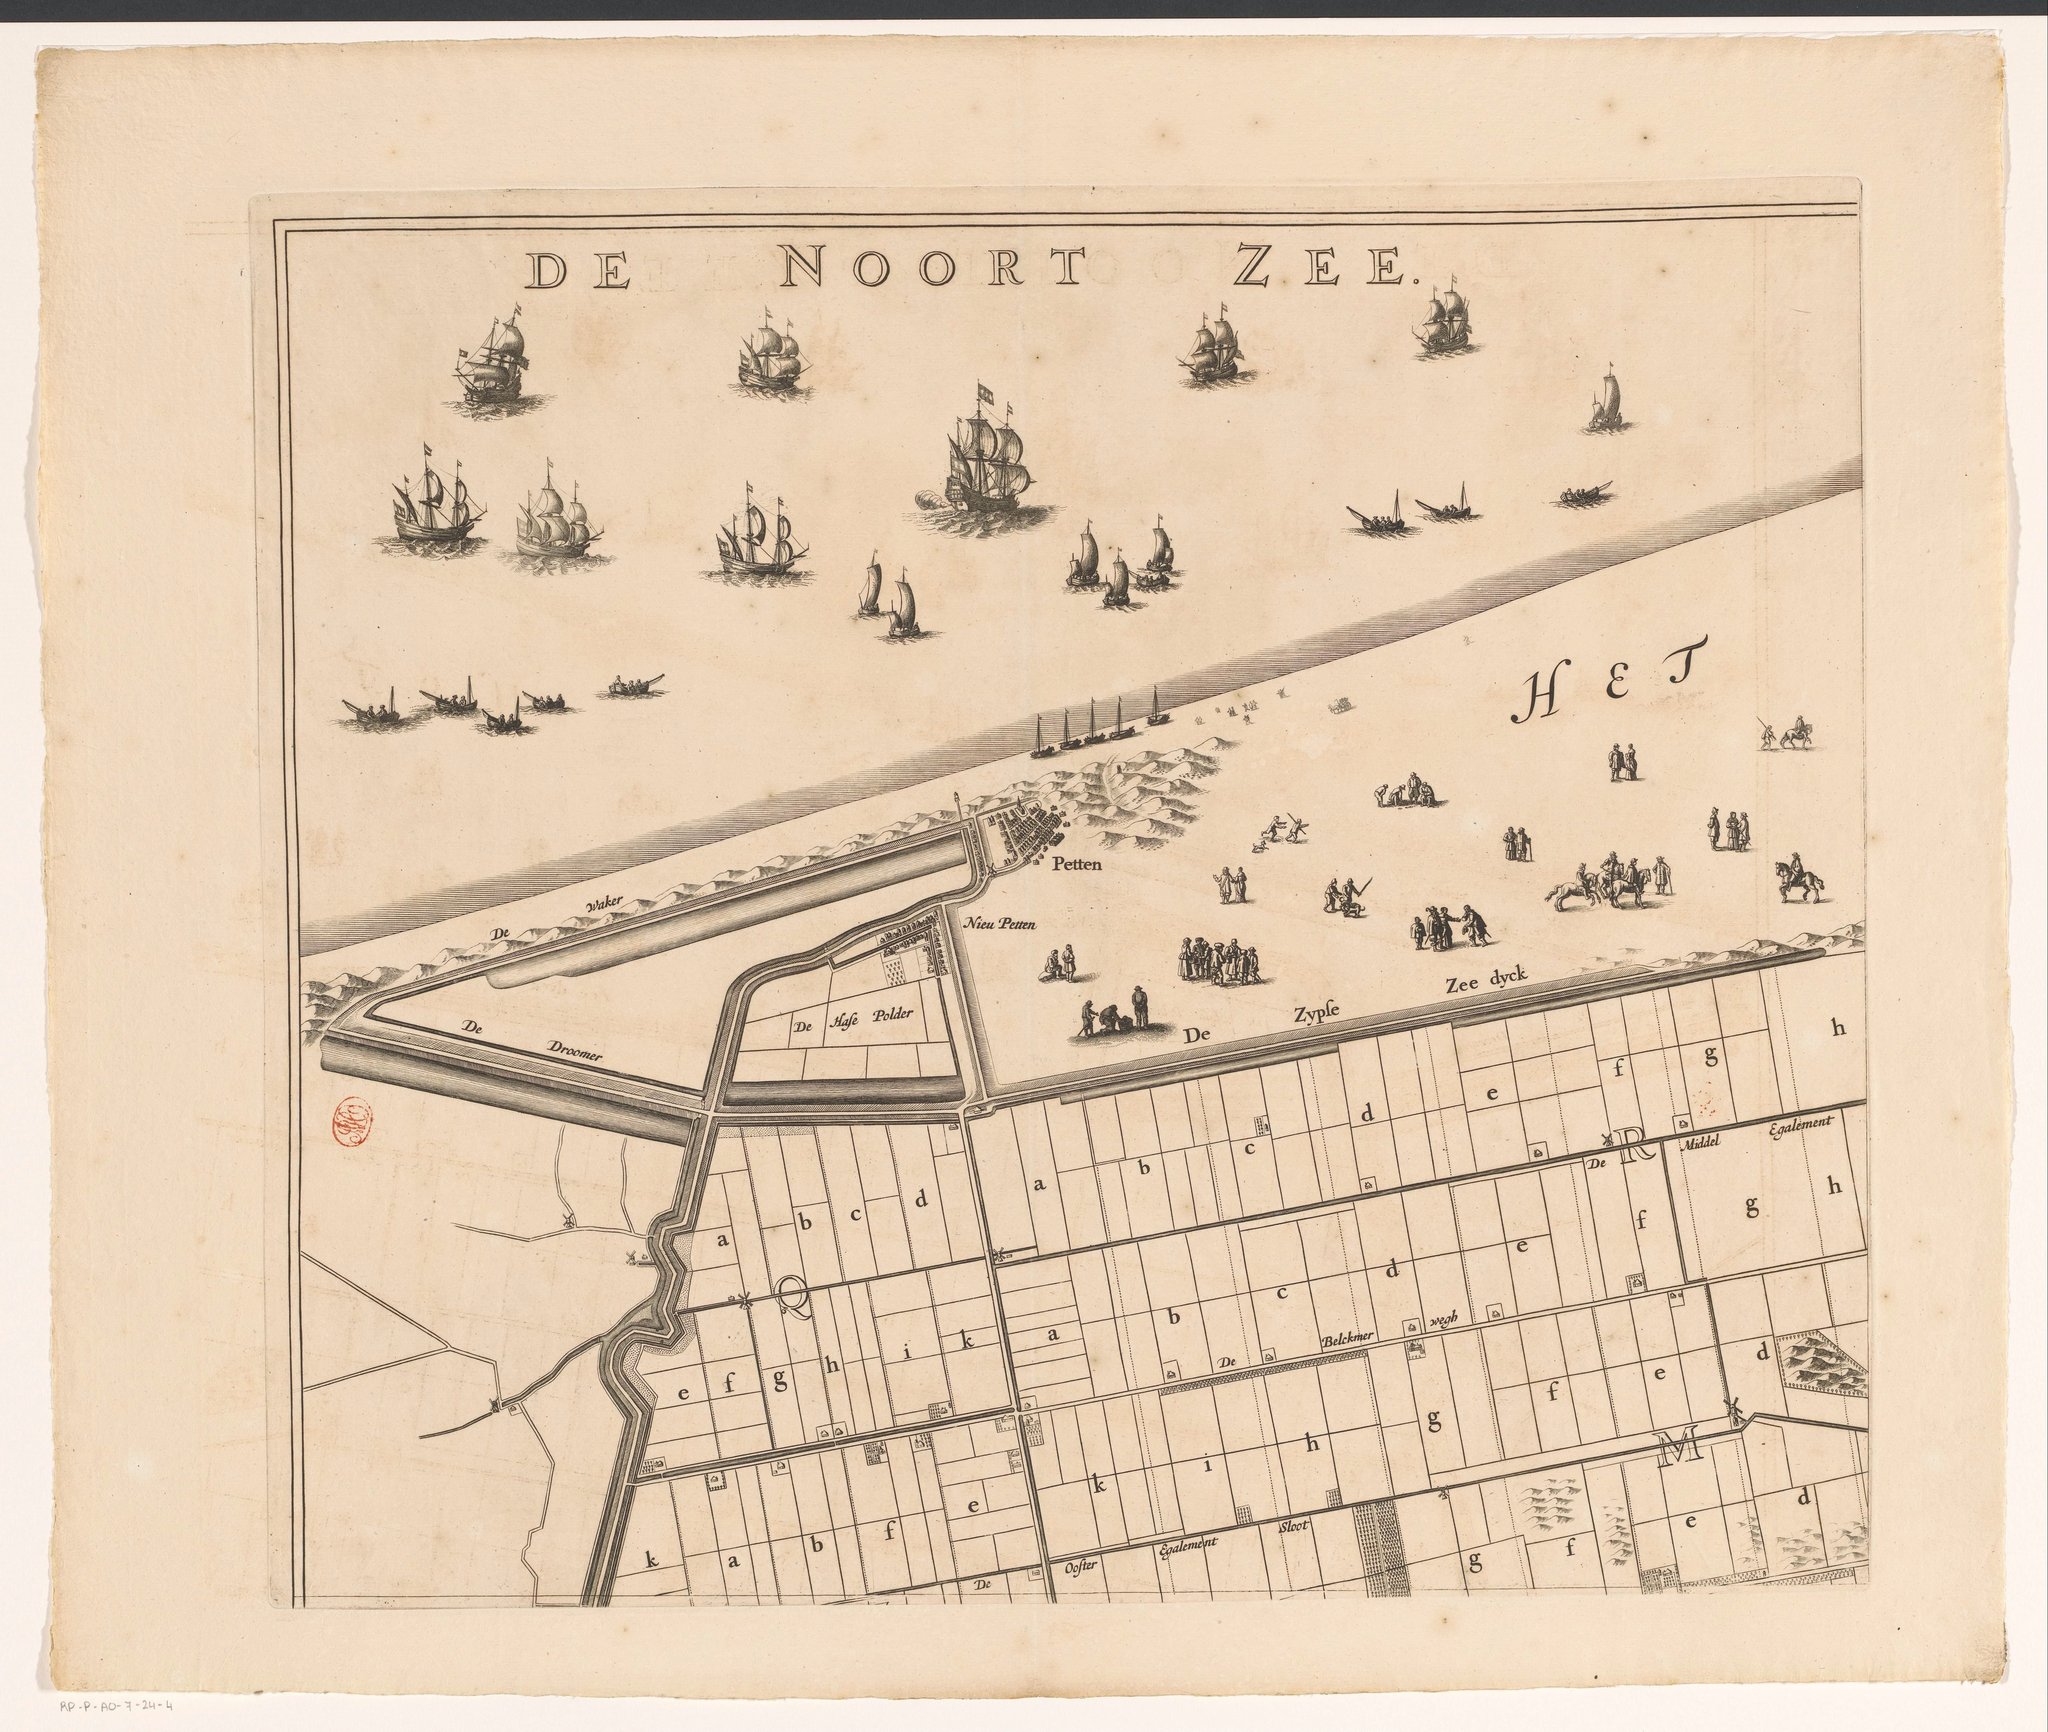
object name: map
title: Afbeelding van de Zyp. Haer waere gelegentheit van dyckage, weegen, watringen en schey-slooten; alle de hofsteden, wooningen en watermolens inde selve geleegen: mitsgaders rechte aenwysinge van de scheydinge haerder groote en kleyne letteren. Begrypende in haren omring de somme van 9060 morgens, yder tot 600 Roeden Hontsbosscher maet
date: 1665-1760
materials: paper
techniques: engraving, etching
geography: gouda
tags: maps of separate countries or regions, polder, reclaimed land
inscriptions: collector's mark: Lugt 2228, collector's mark: Lugt 195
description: Deel (linksboven) van een kaart van de Zijpepolder.